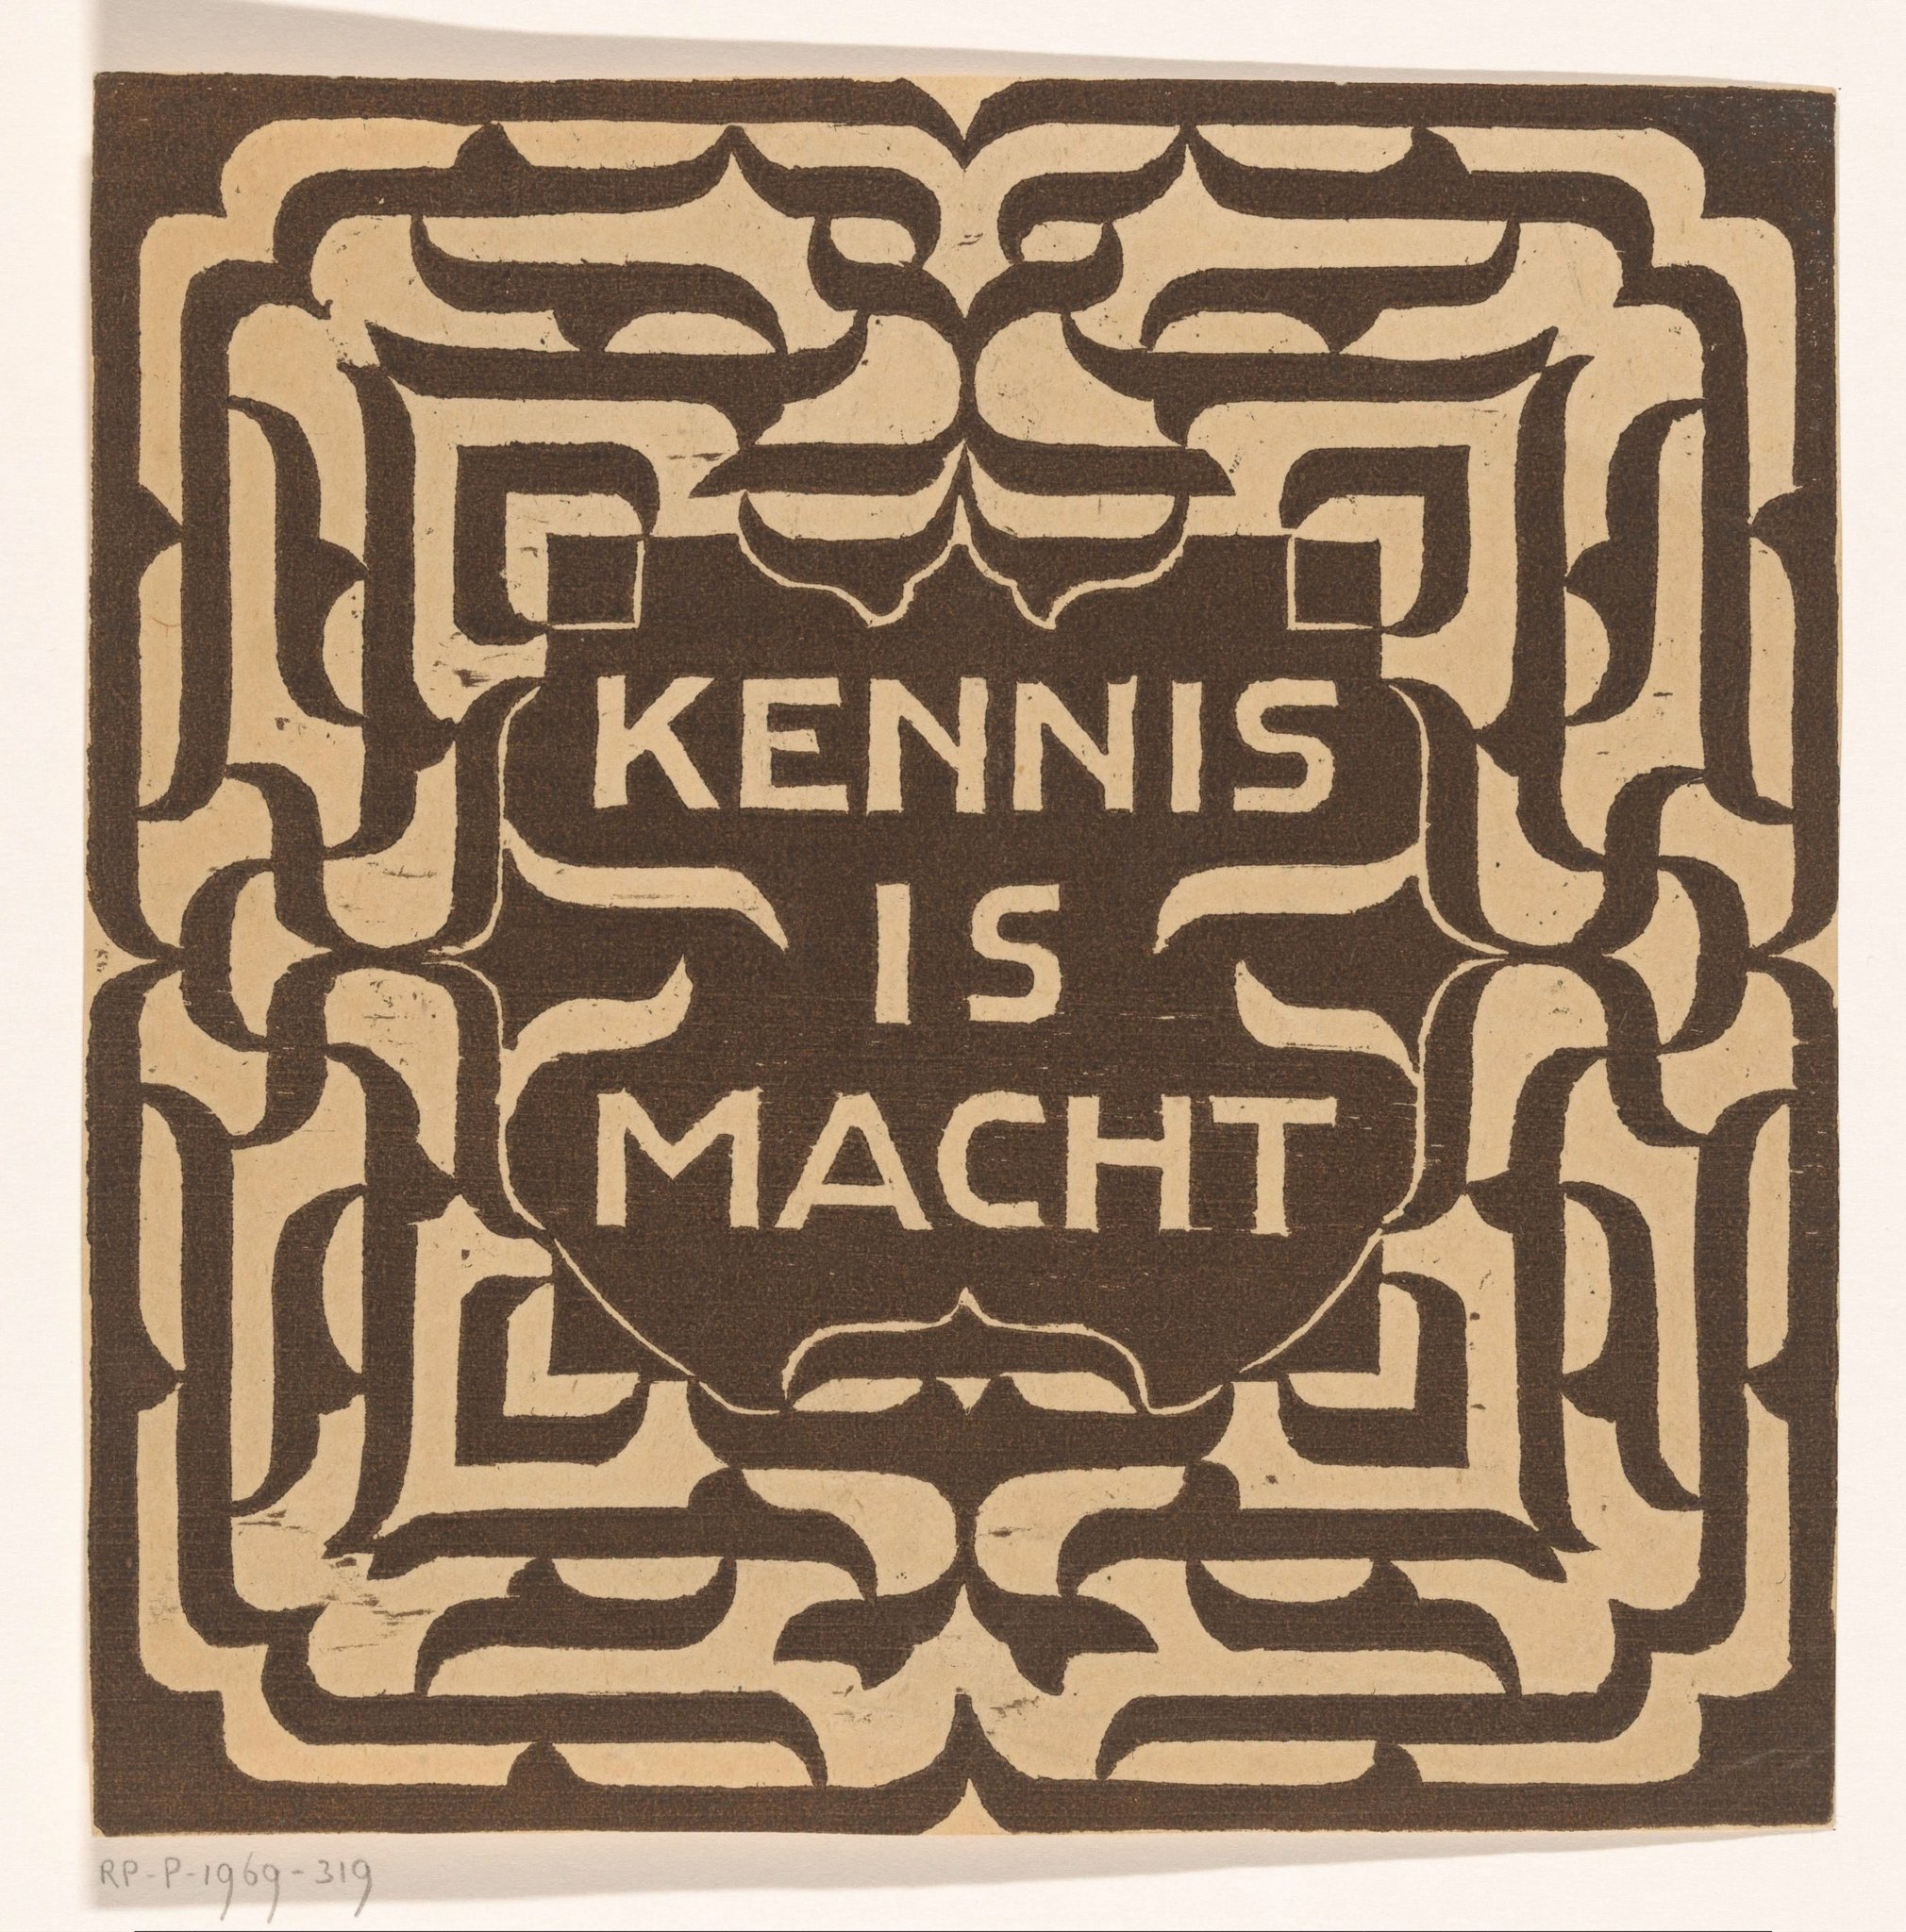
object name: print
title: Kennis is macht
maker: carel adolph lion cachet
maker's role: draughtsman, print maker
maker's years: 1864-1945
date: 1874-1945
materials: paper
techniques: woodcut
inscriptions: collector's mark: Lugt 2228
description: Decoratief ontwerp met in het midden de woorden 'Kennis is macht'.